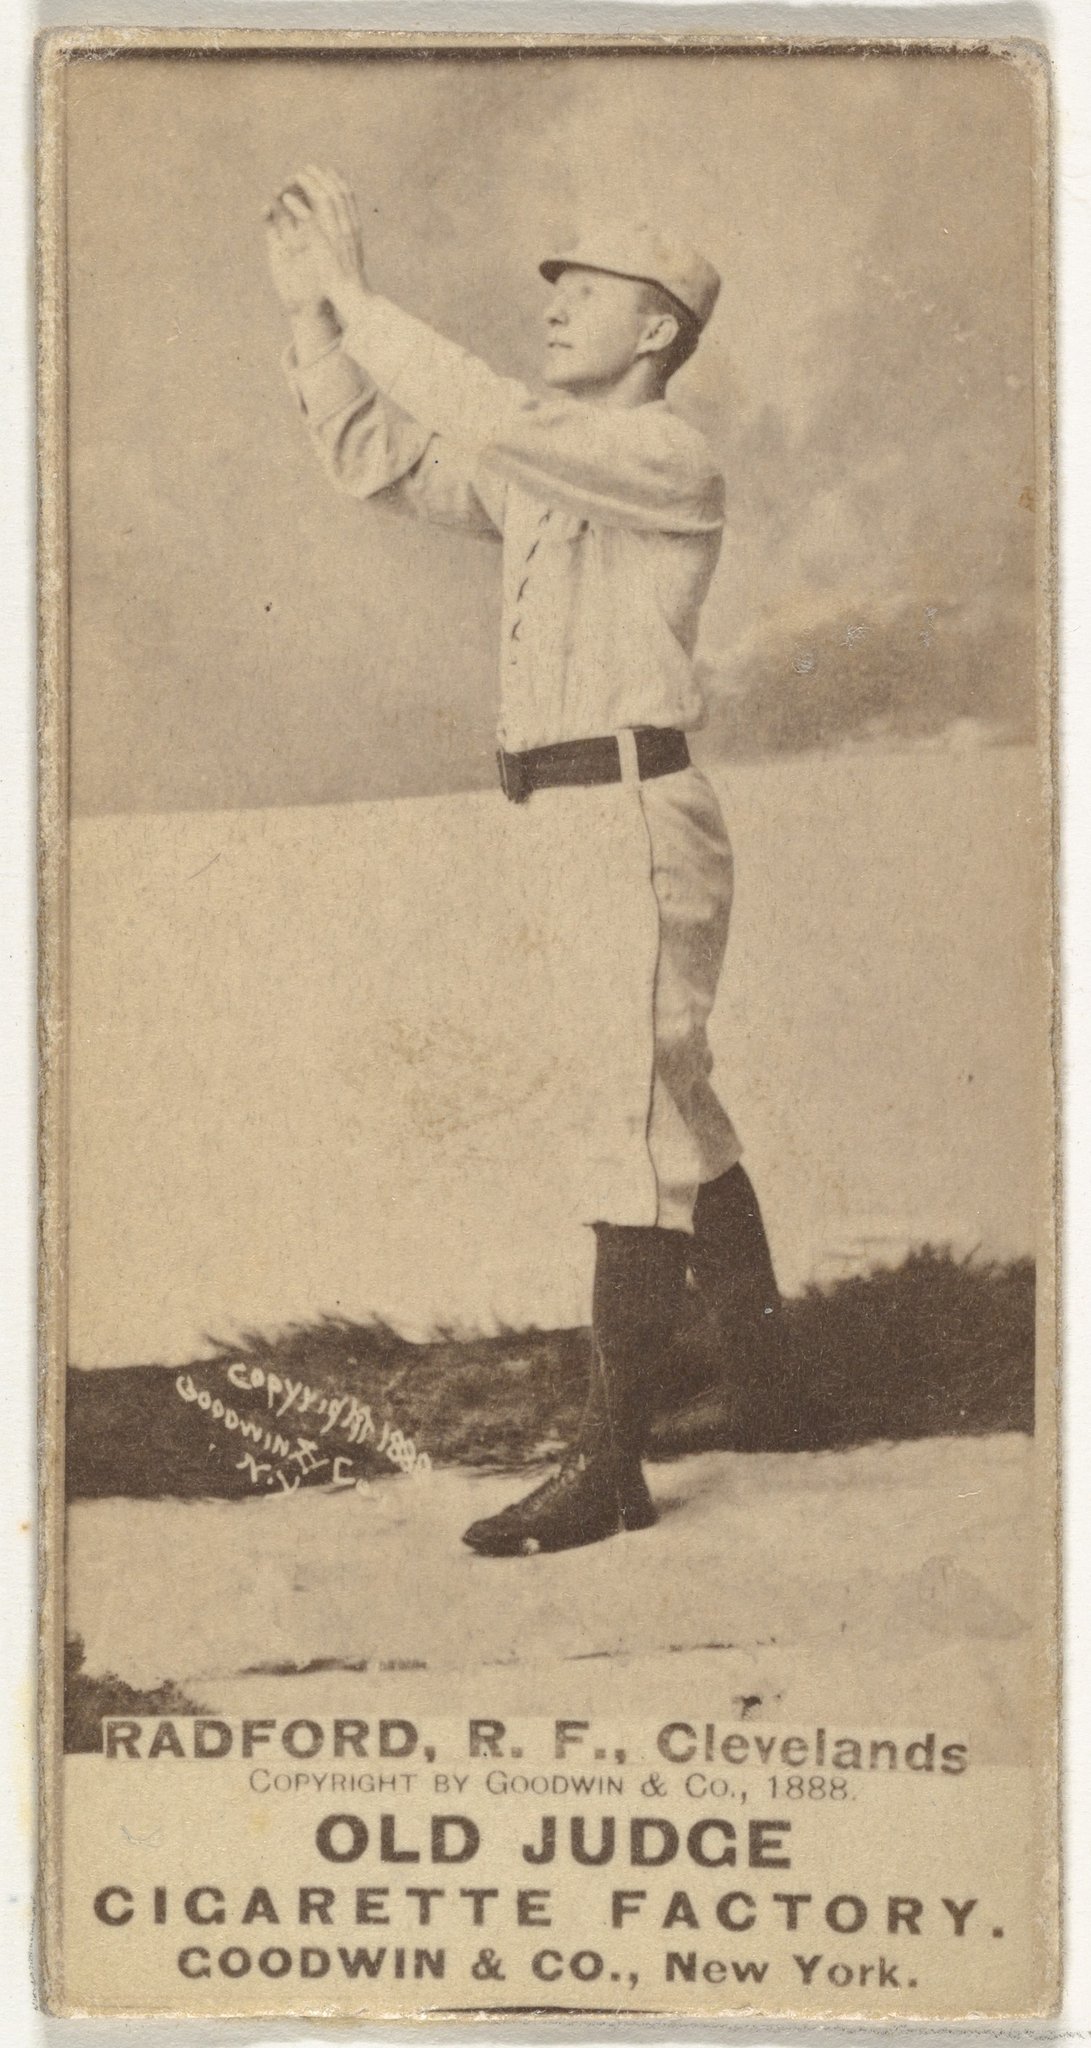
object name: baseball card, photograph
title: Paul Revere "Shorty" Radford, Right Field, Cleveland, from the Old Judge series (N172) for Old Judge Cigarettes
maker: goodwin & company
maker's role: publisher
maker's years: 1850-1950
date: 1888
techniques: albumen silver print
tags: men,portraits,baseball,athletes